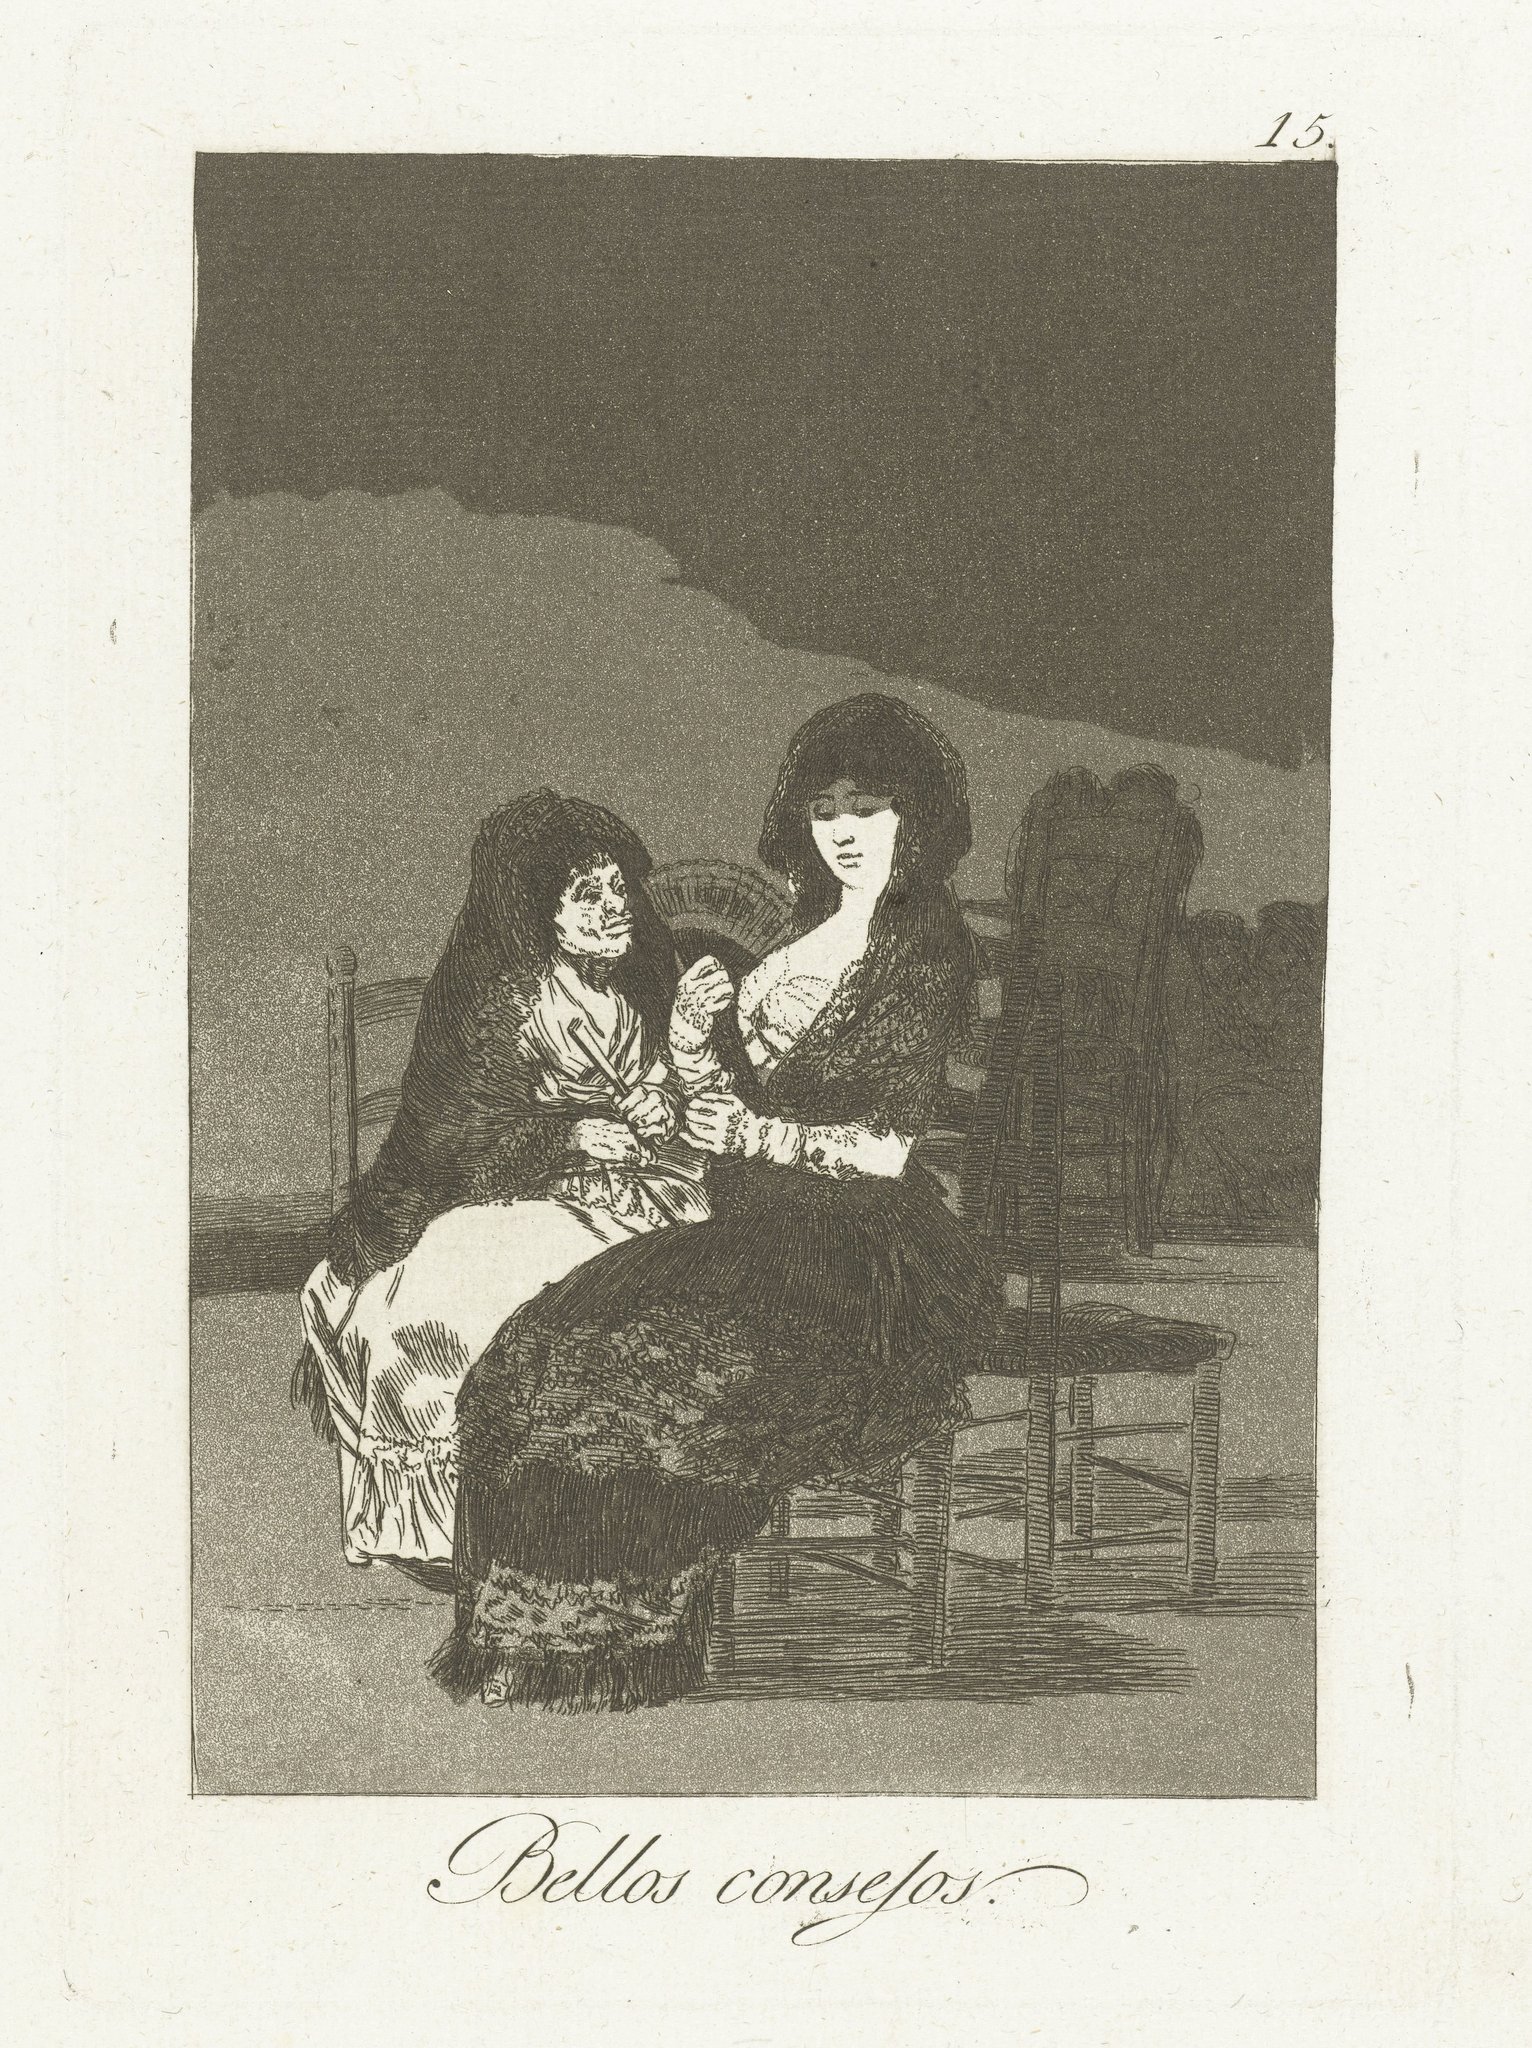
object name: print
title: Goede raadgevingen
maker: francisco de goya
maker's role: draughtsman, painter, print maker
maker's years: 1746-1828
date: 1797-1799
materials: paper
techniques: aquatint, etching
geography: spain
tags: adolescent, young woman, maiden, old woman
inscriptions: collector's mark: Lugt 2228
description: Een jonge en een oude vrouw zittend op een stoel, beide met een waaier in de hand. Vijftiende prent uit de serie Los Caprichos.